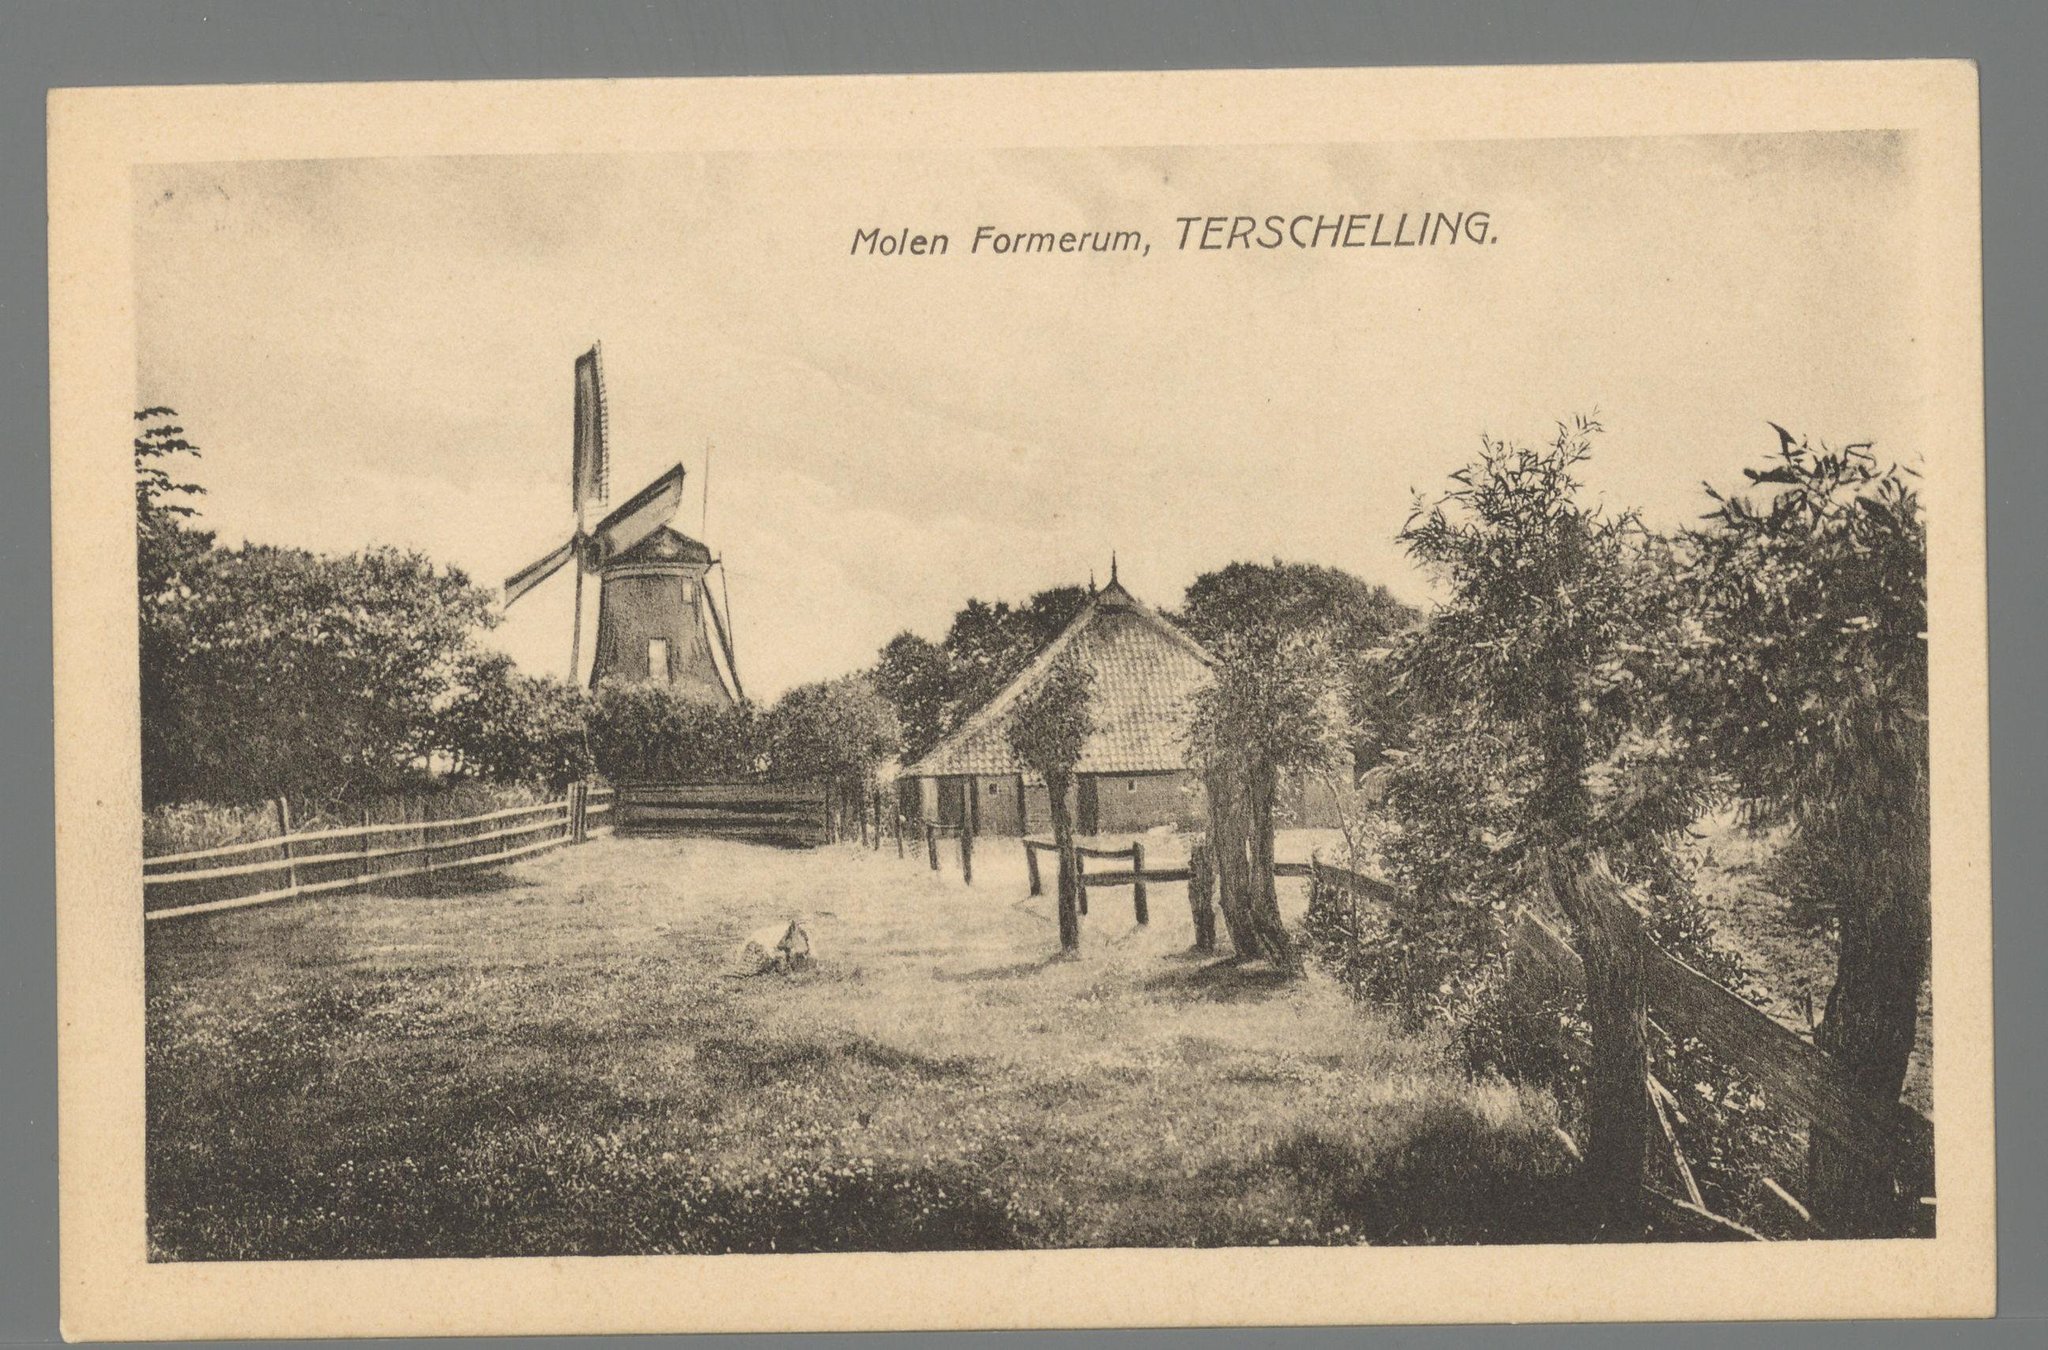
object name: ansichtkaart, prentbriefkaart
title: Molen Formerum, Terschelling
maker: Anonymous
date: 1913-1930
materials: cardboard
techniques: photograph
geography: terschelling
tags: windmill in landscape